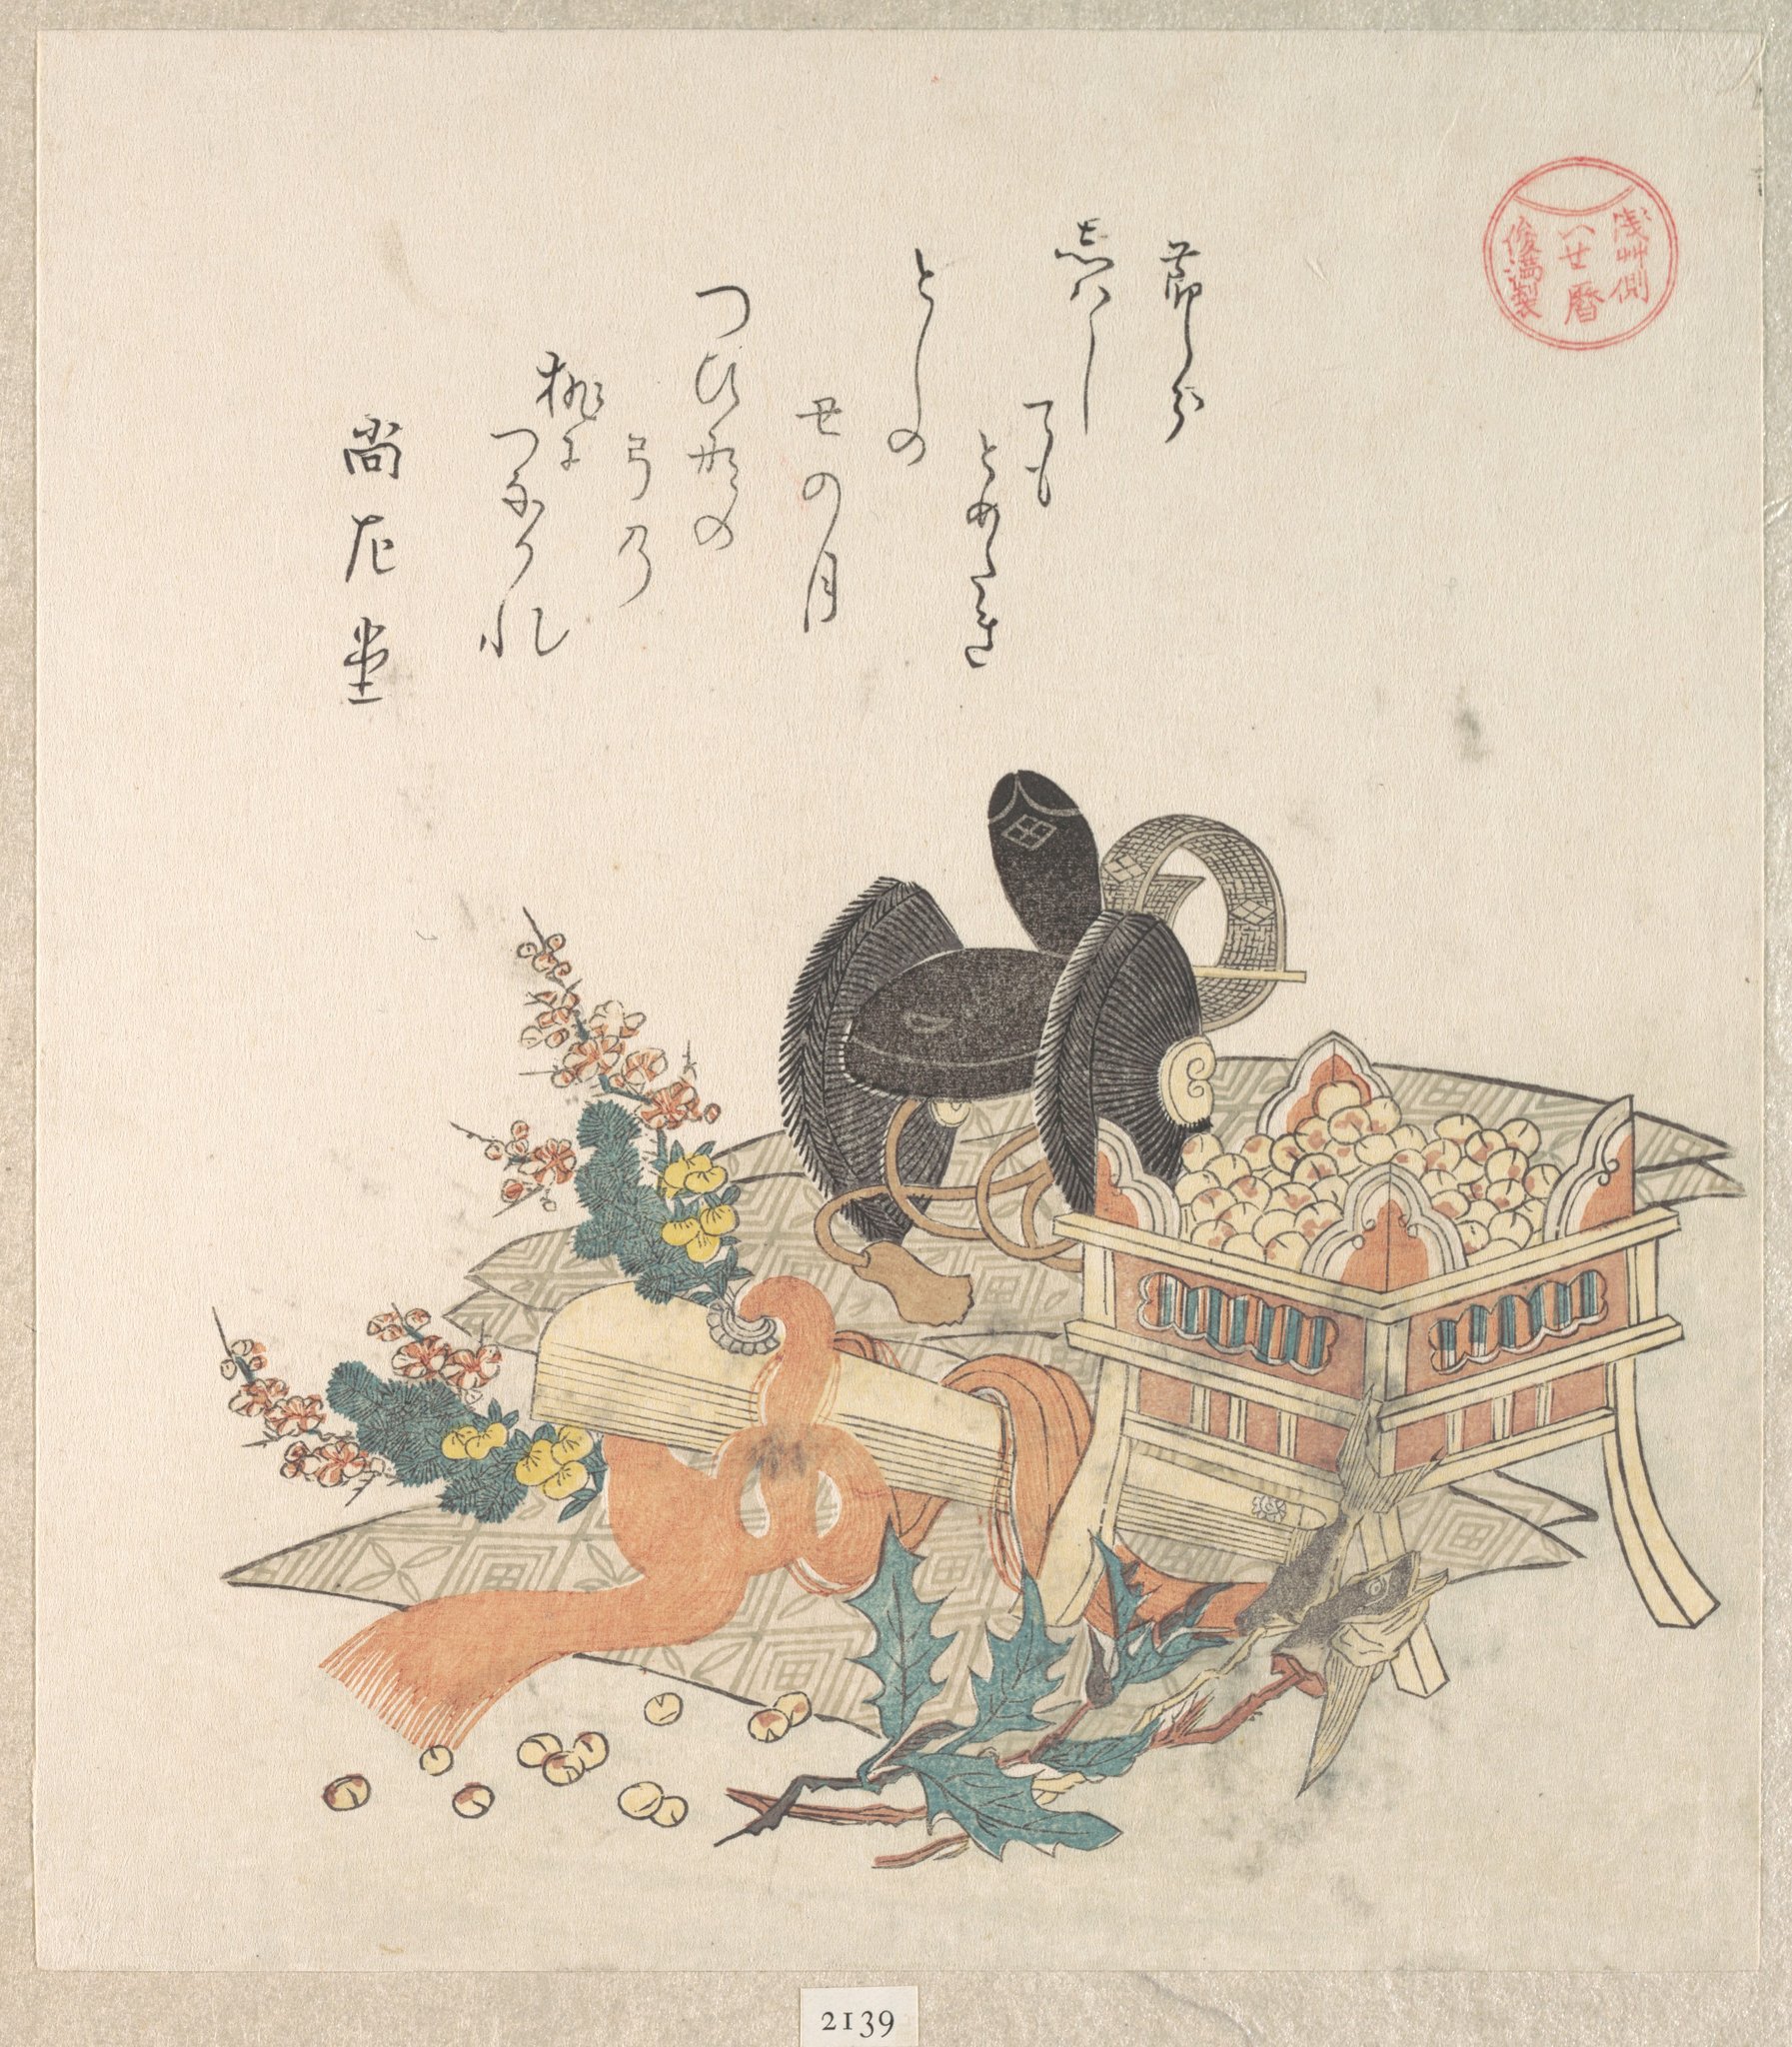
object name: print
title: “Beans for Tossing During Setsubun Exorcism Ceremony,” from the series Ise Calendars for the Asakusa Group (Asakusa-gawa Ise goyomi) From the Spring Rain Collection (Harusame shū), vol. 2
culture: japanese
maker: kubo shunman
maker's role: artist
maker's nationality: japanese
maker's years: 1757-1820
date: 1810-1819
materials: ink, paper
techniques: surimono, woodblock print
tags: flowers,leaves